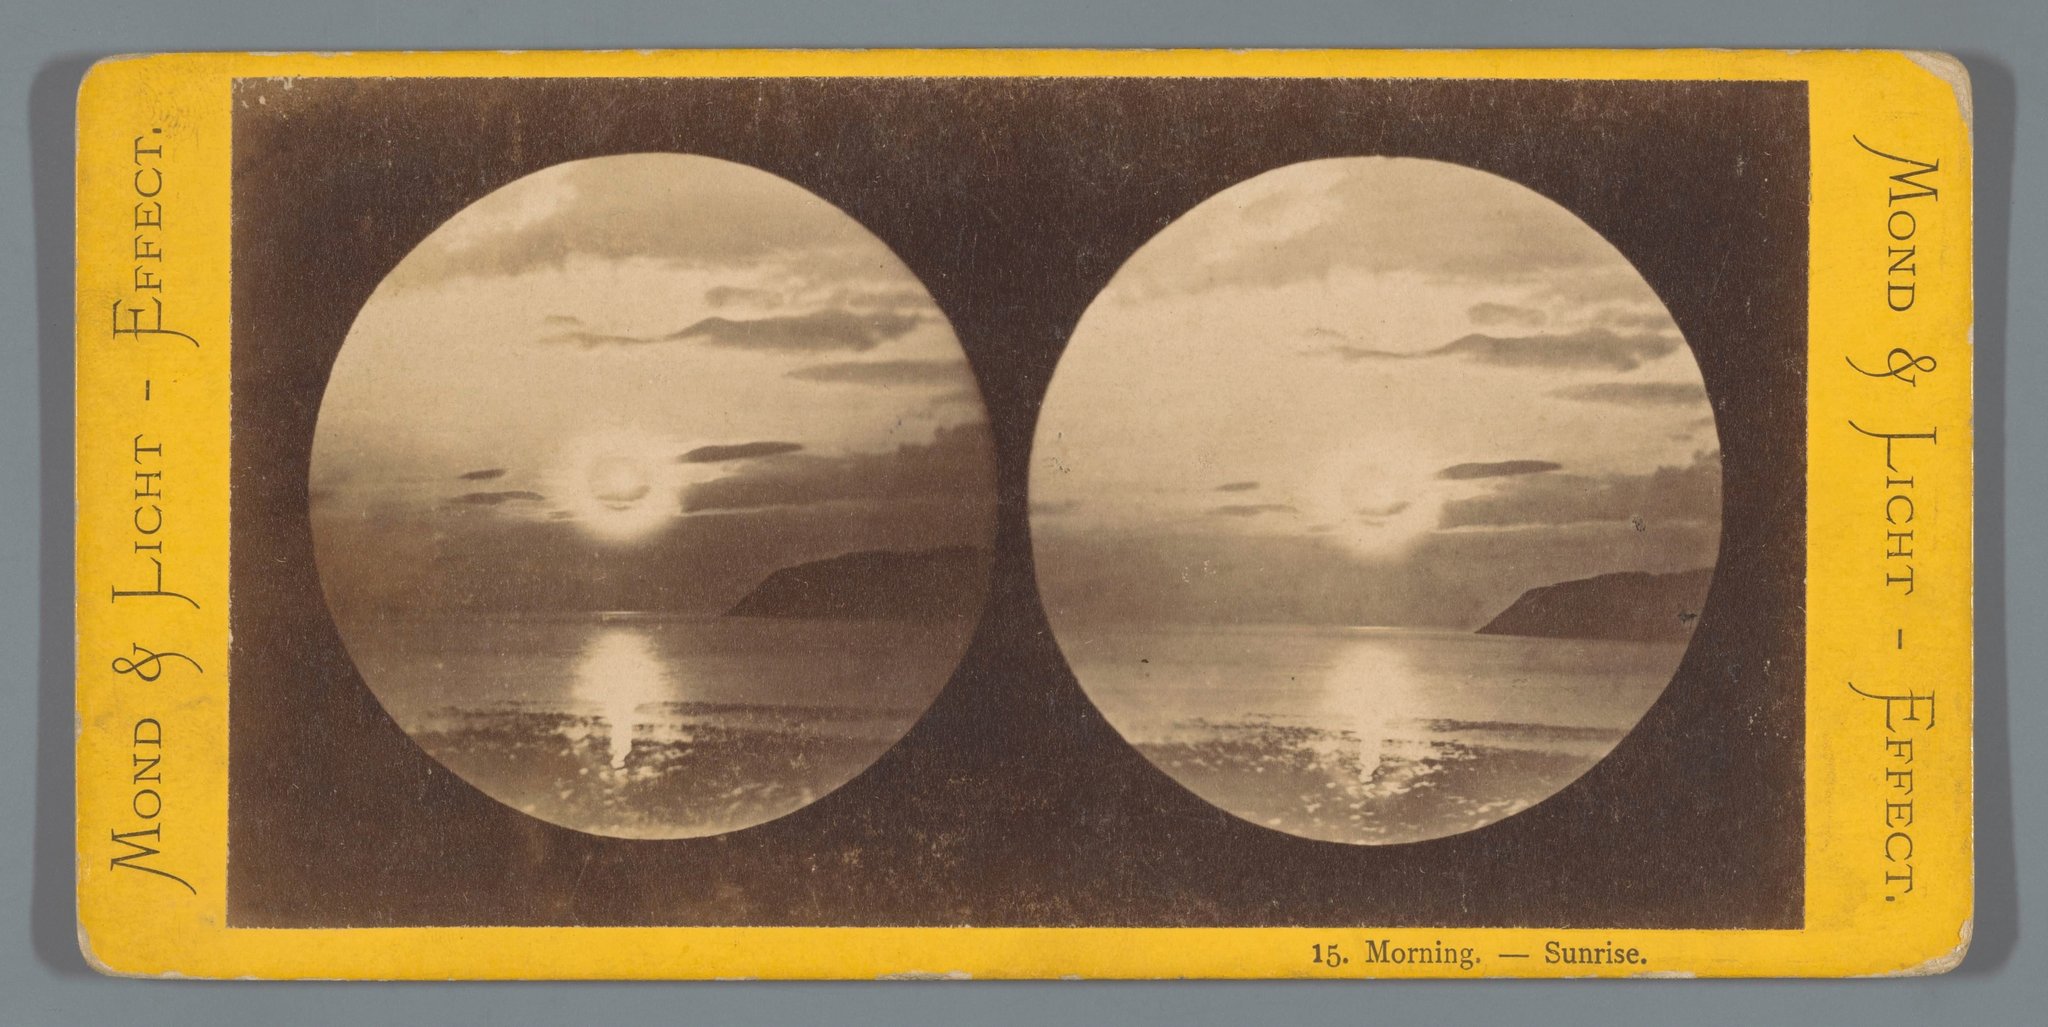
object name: stereograph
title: Mond & Licht-Effect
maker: Anonymous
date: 1868-1890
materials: cardboard, paper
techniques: albumen print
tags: ocean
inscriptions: number: ‘15’